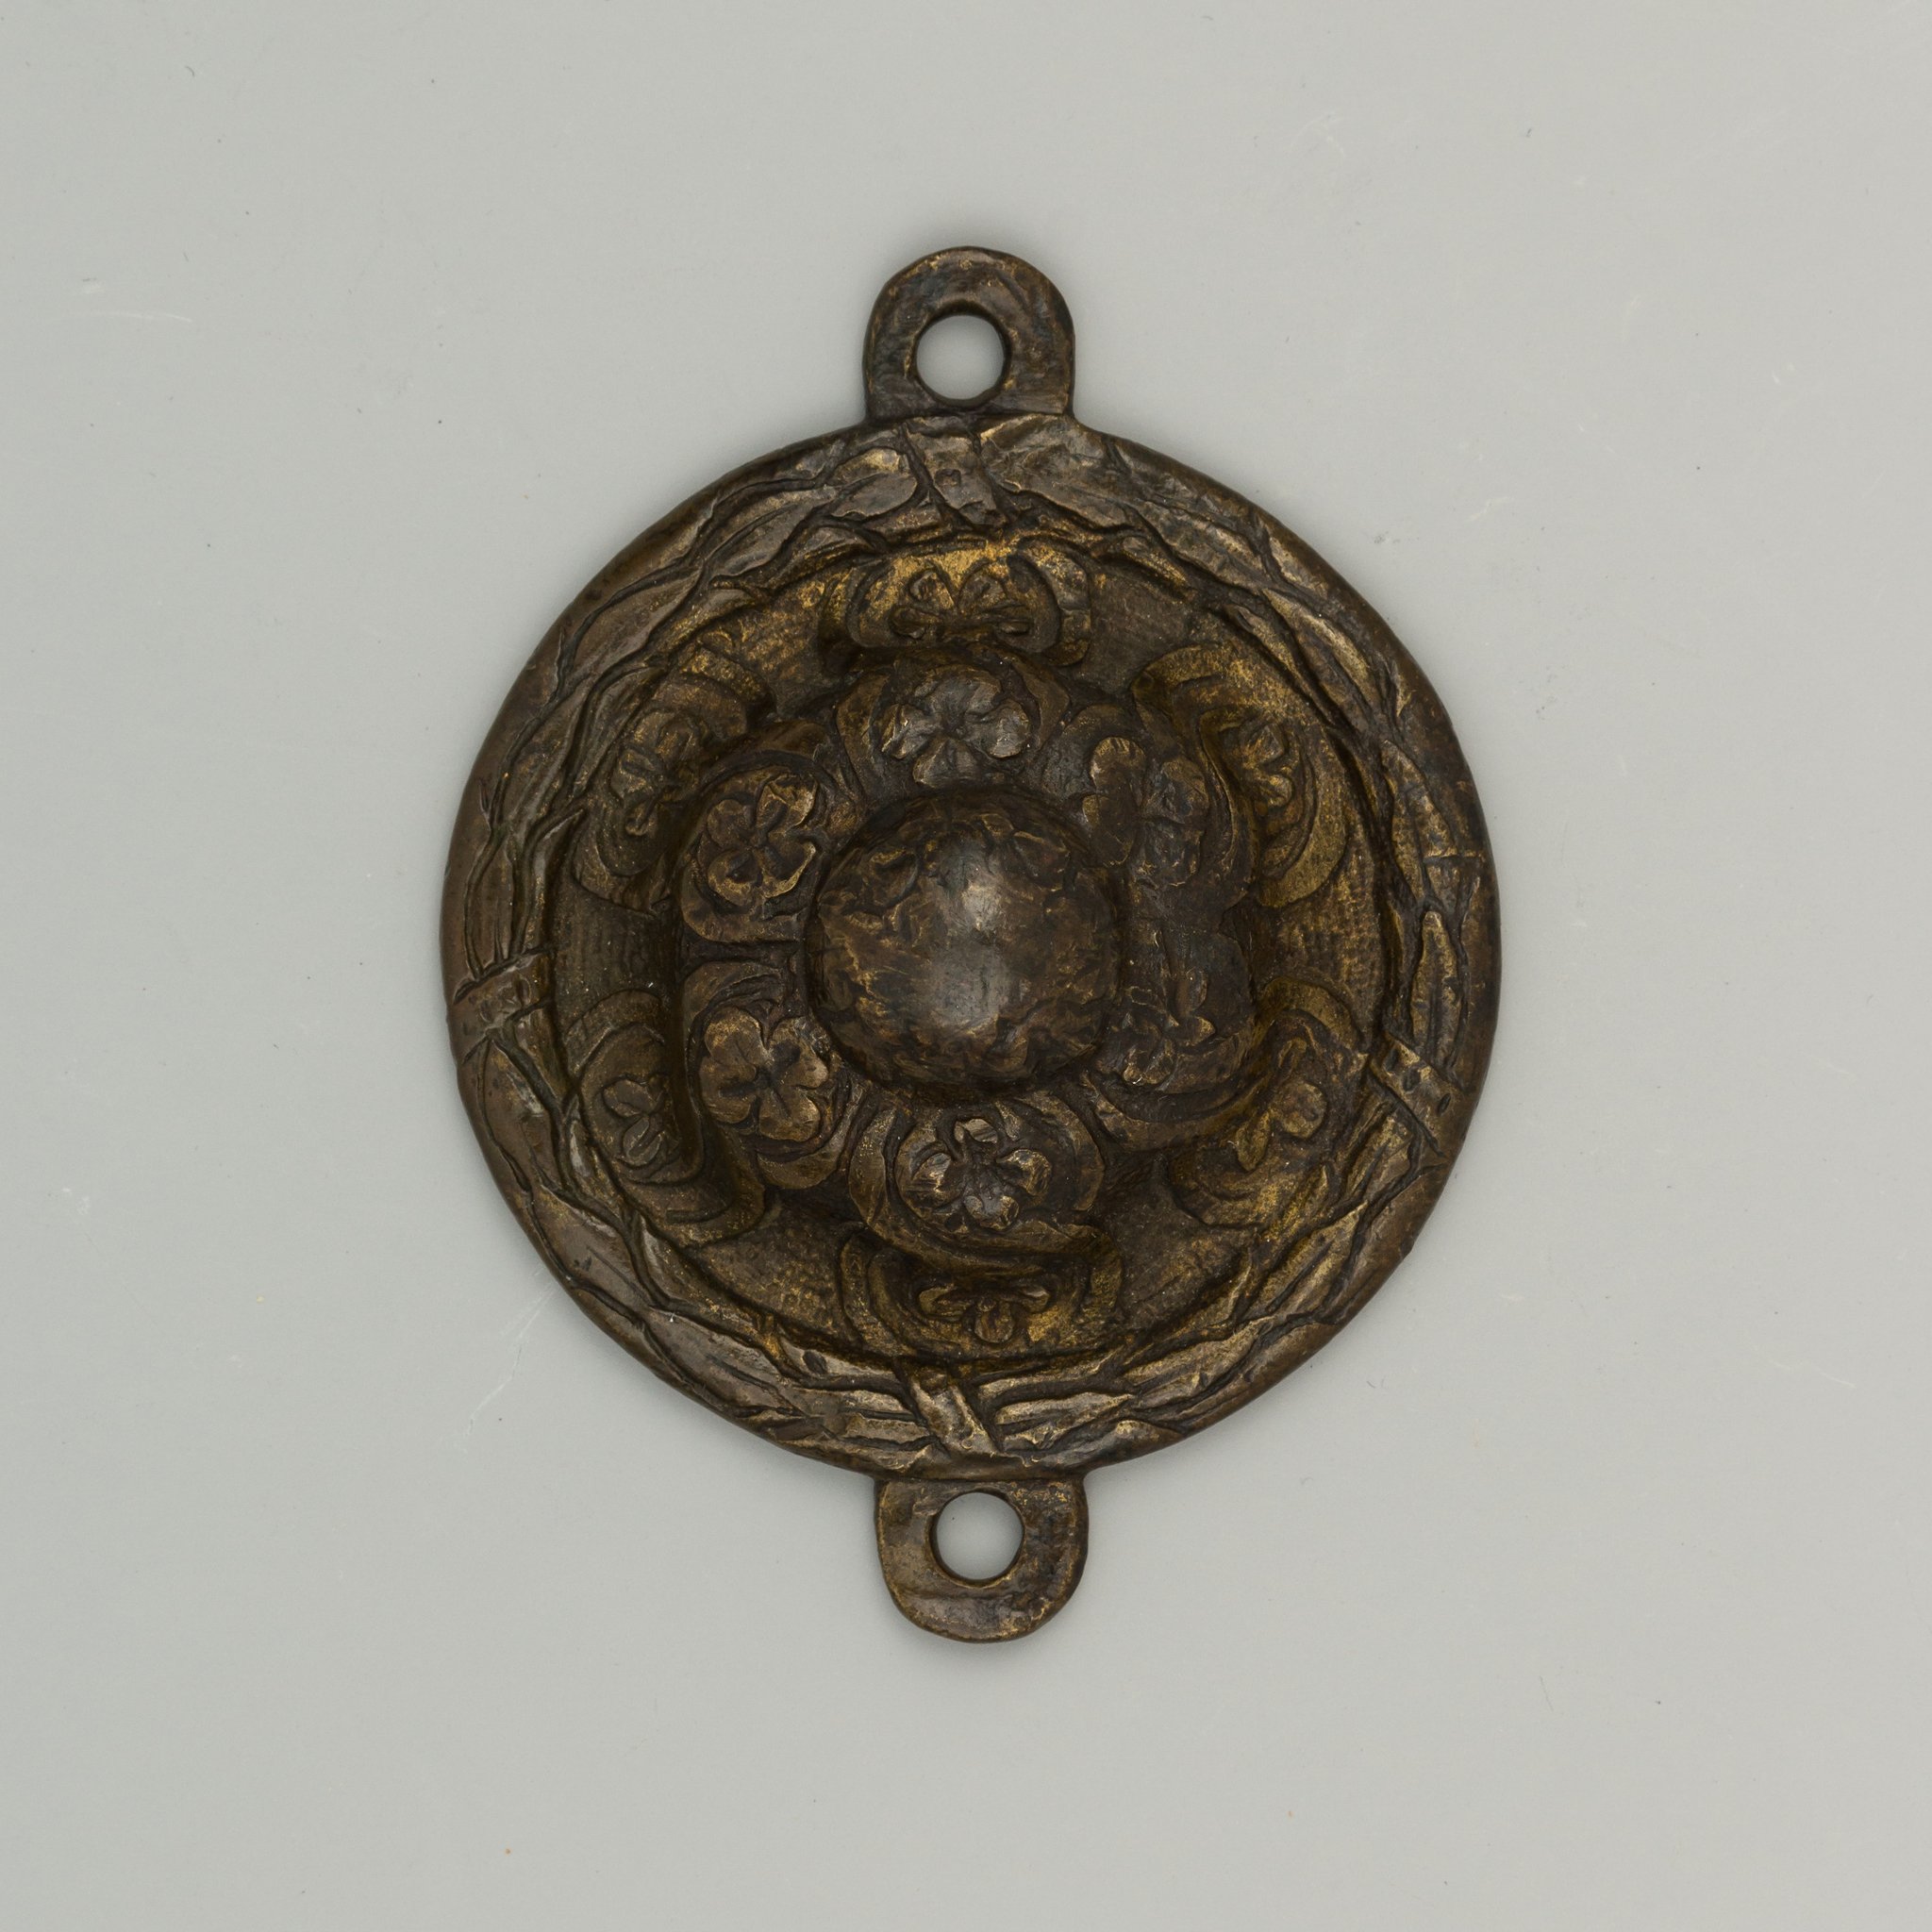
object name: bit bos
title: Bit Boss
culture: european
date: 1667-1733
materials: copper alloy, gold